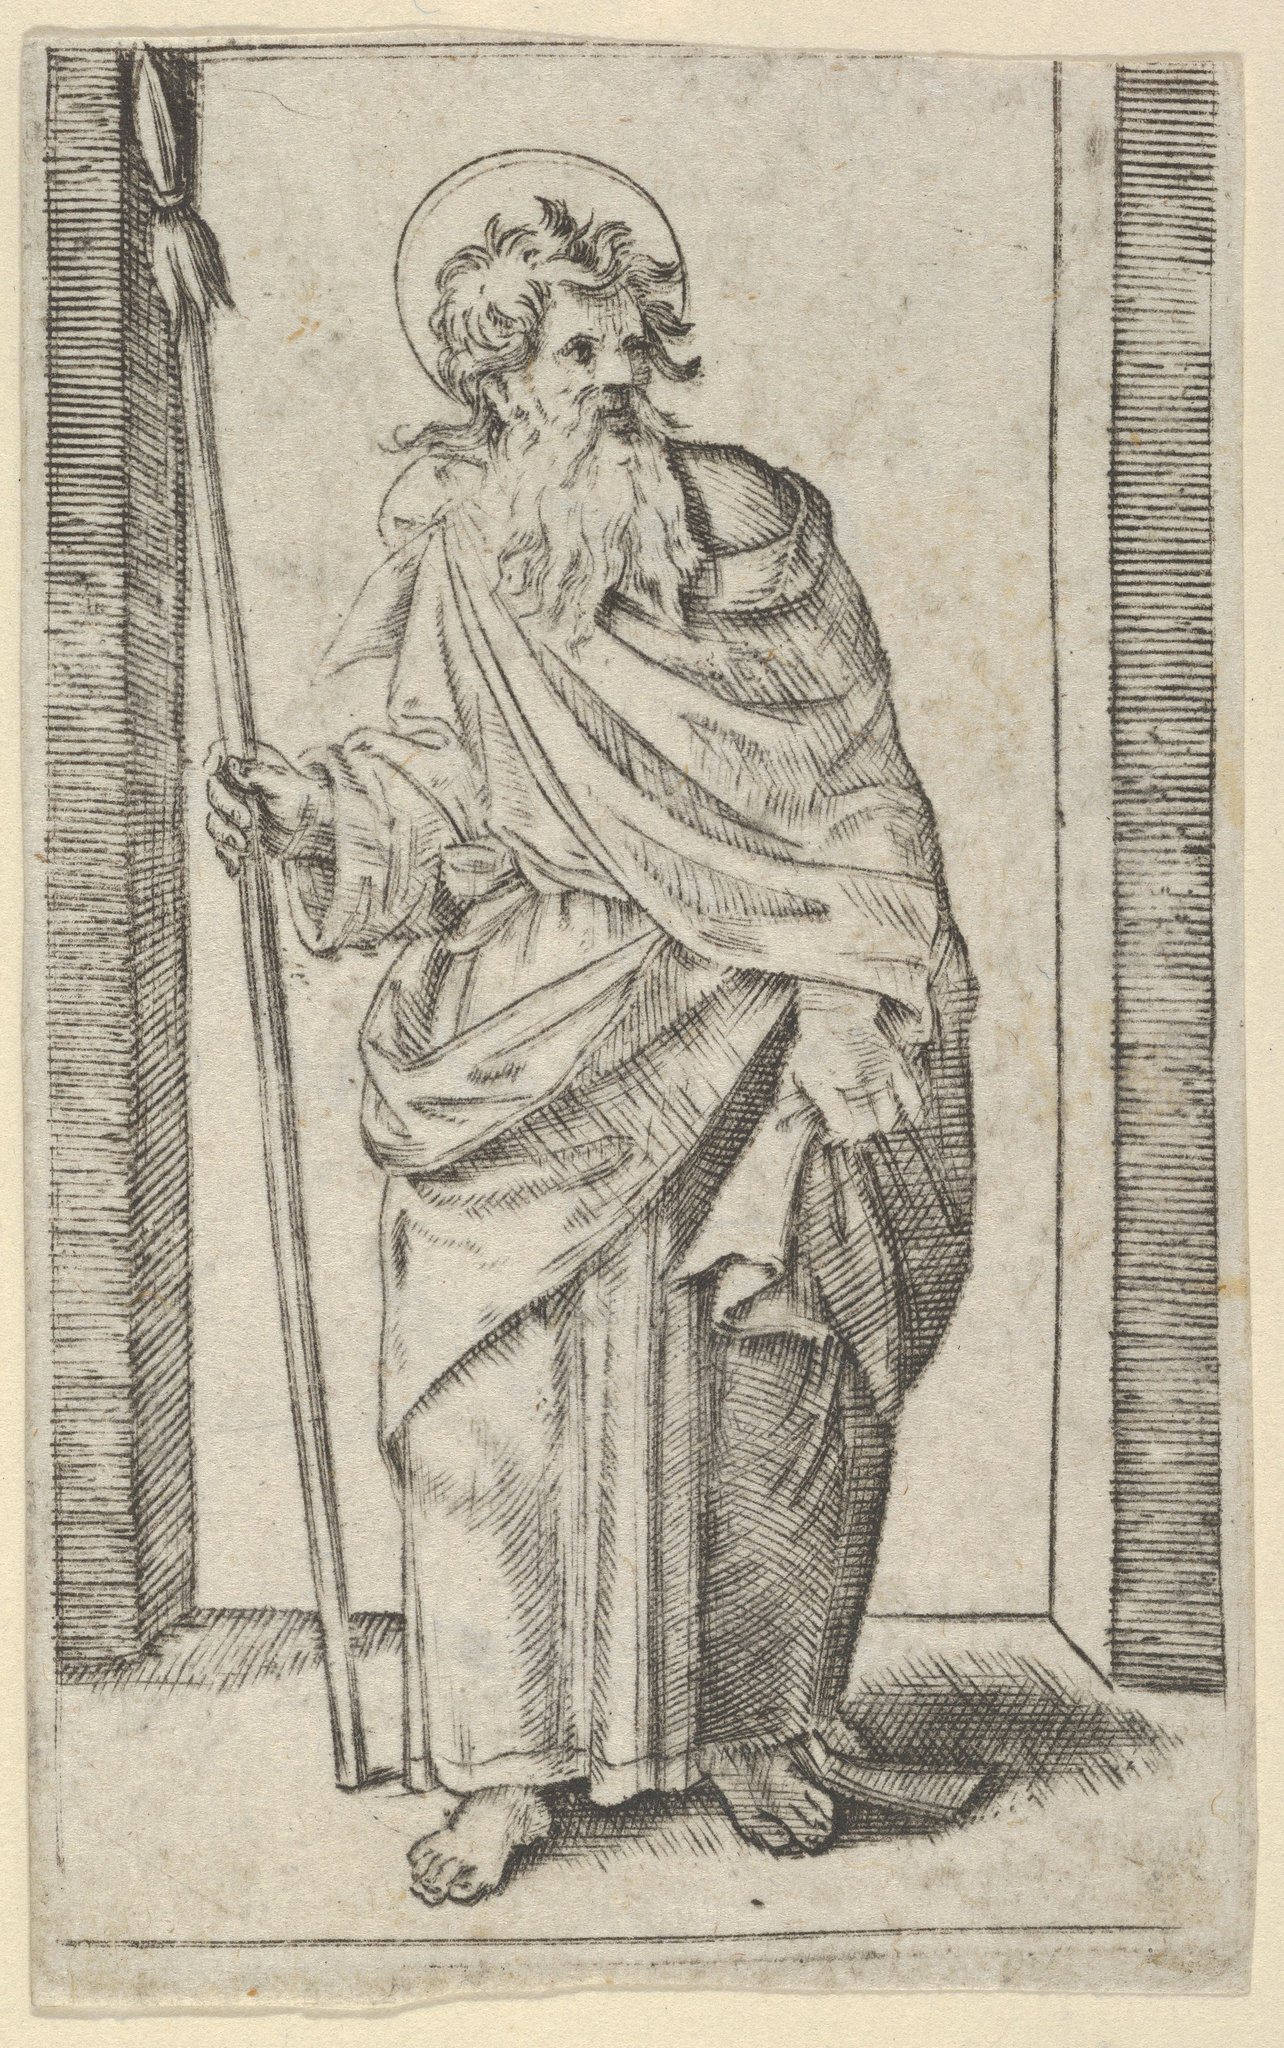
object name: print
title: Saint Matthias, from "Piccoli Santi" (Small Saints)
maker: marcantonio raimondi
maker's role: artist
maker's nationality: italian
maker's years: 1475-1534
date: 1500-1534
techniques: engraving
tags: spears,men,saints